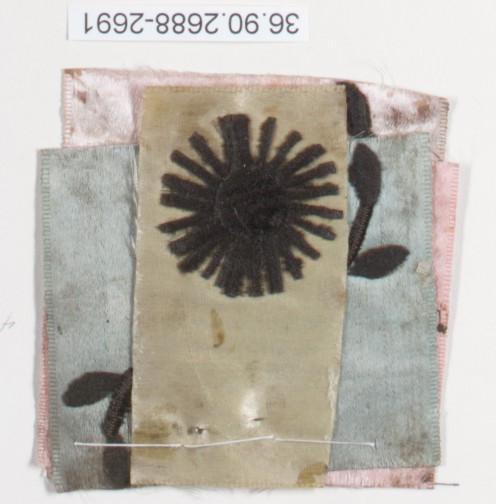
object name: ribbon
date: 1801-1900